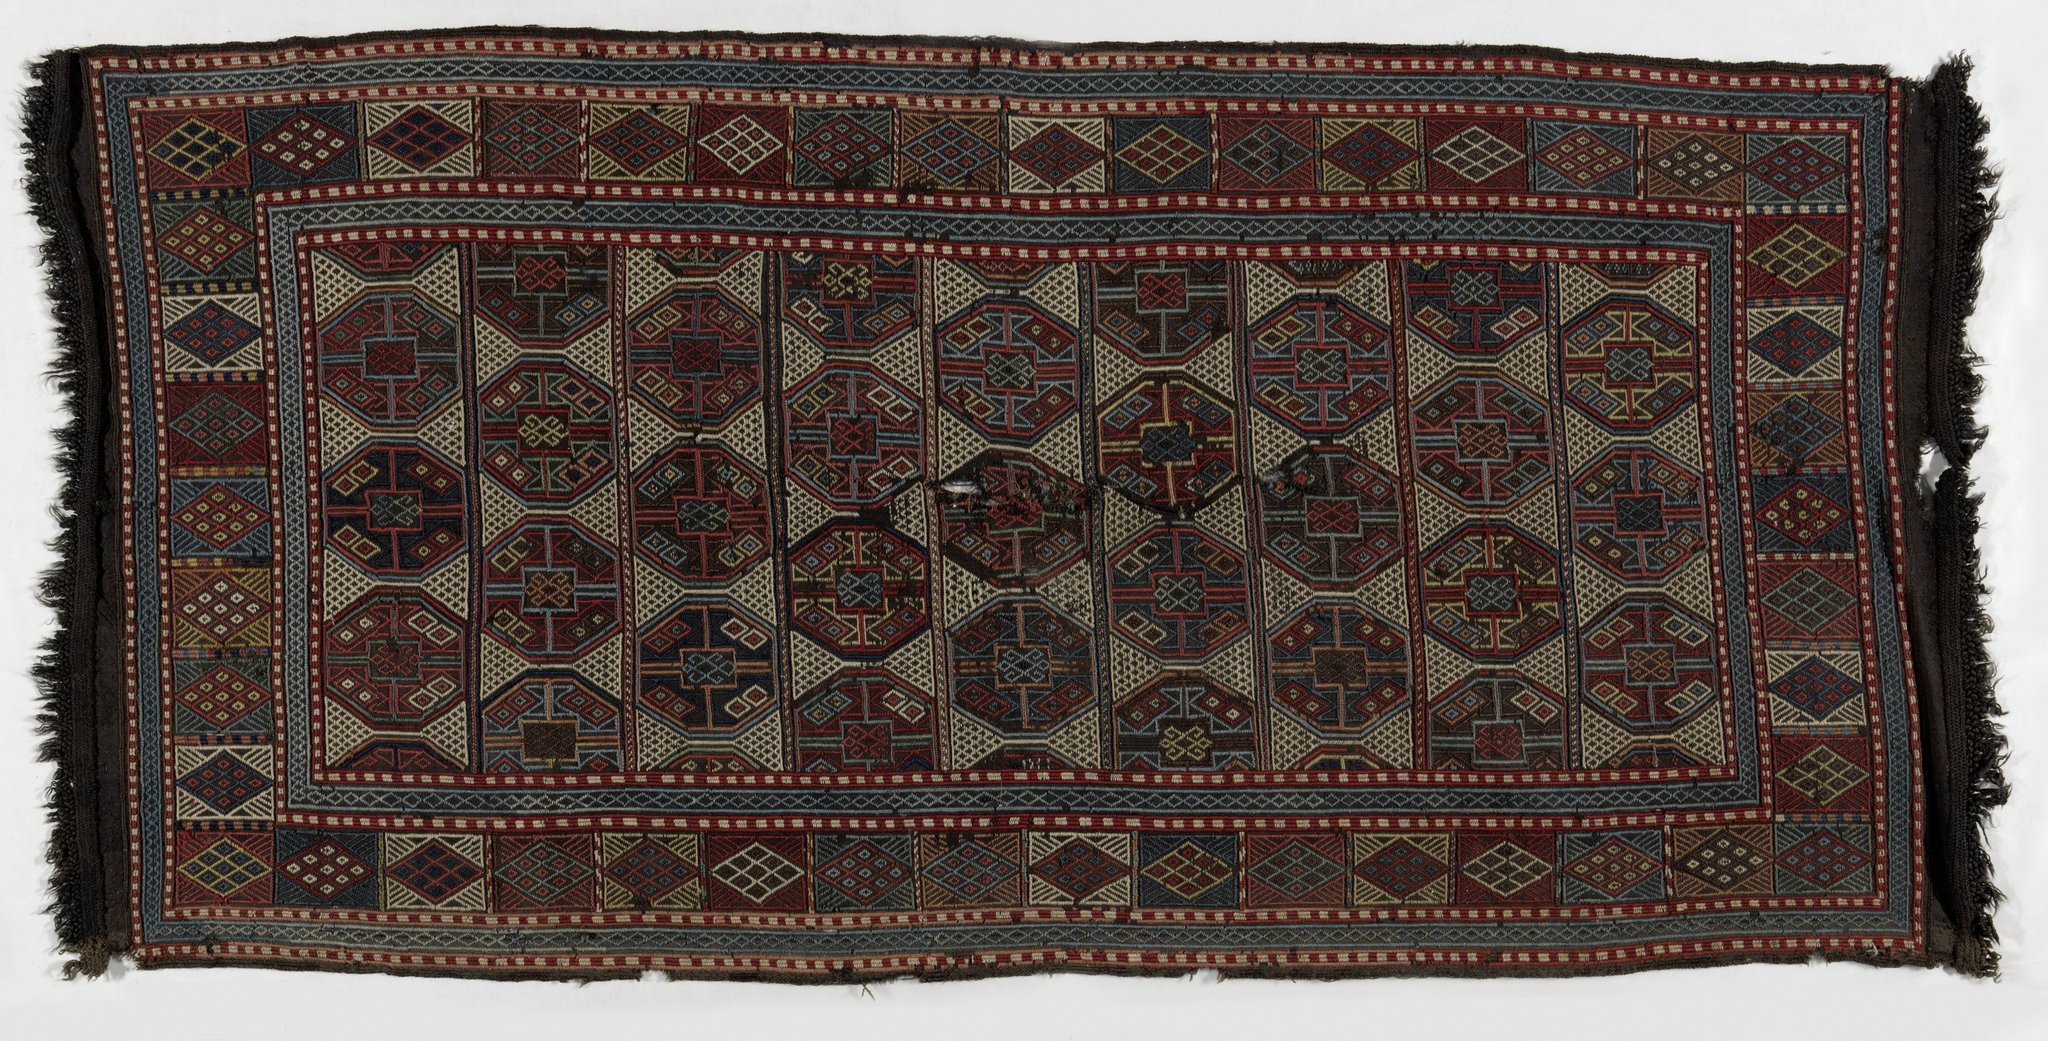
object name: oriental rug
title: Tapijt met oneindig rapport van verspringende rijen aaneengesloten guls, rand met dambordpatroon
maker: Anonymous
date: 1800-1900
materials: wool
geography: turkmenistan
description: Oosters tapijt in glad weefsel met brocheringen. In het middenveld een oneindig rapport verspringende rijen aaneengesloten guls met een rechthoek in het centrum. Randen versierd met blokken met ruiten met dambordpatroon.